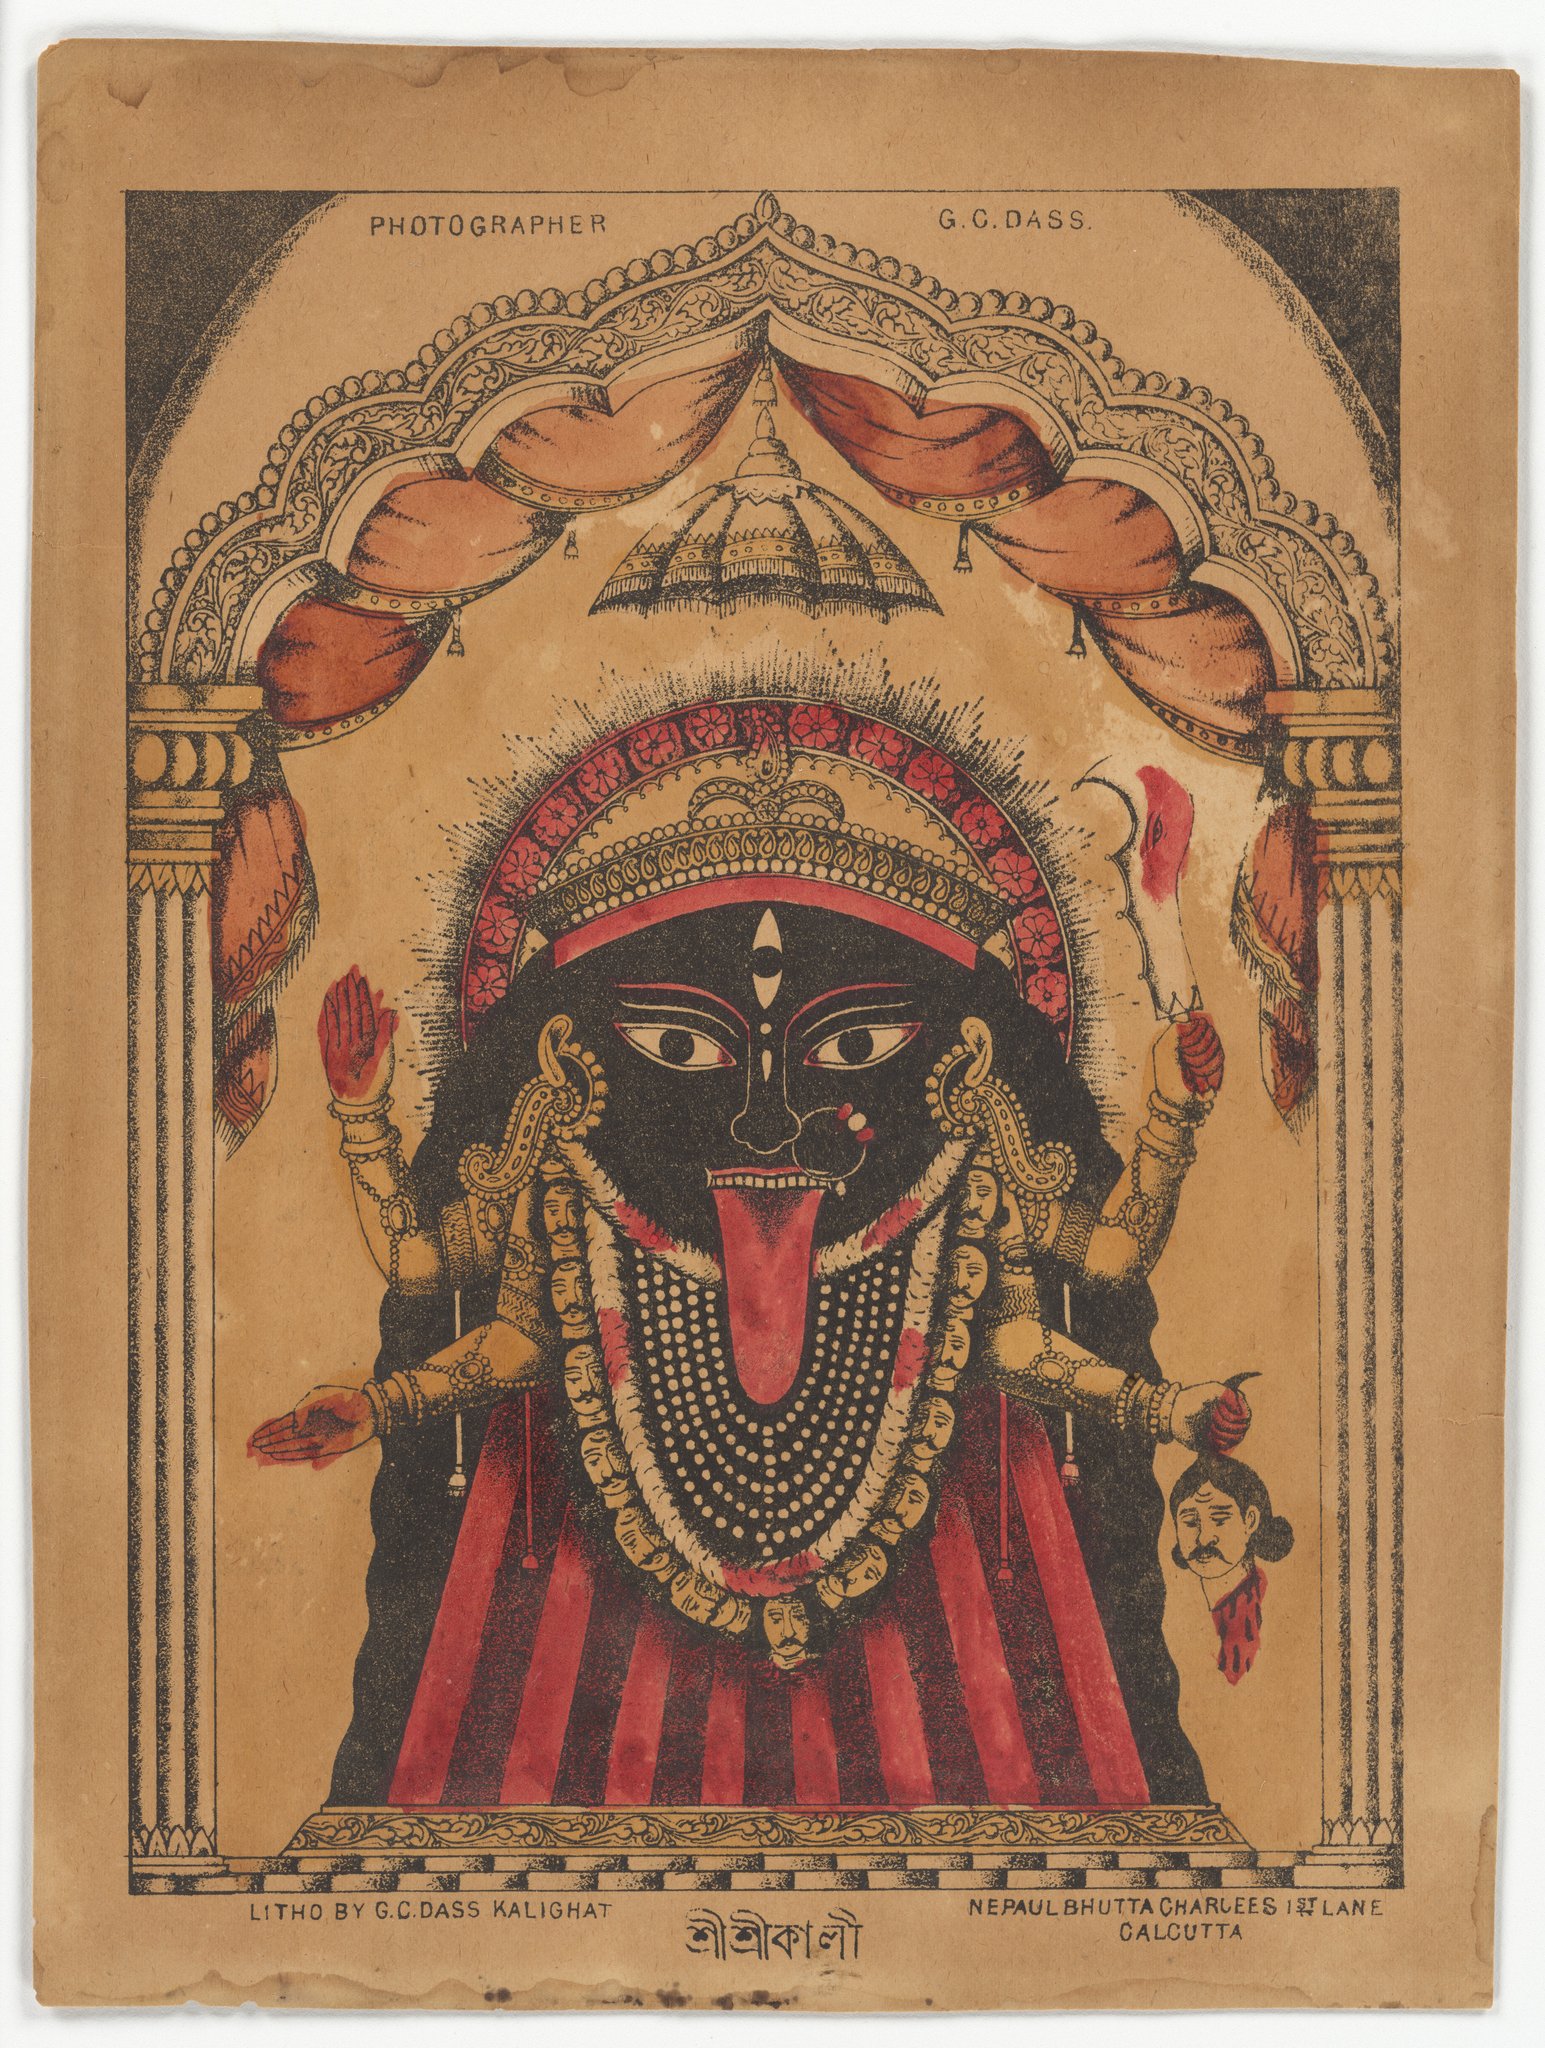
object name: lithograph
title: Sri Sri Kali (recto); Kali (verso)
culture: west bengali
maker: g. c. dass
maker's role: artist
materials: glaze, watercolor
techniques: hand coloring, lithograph, printing